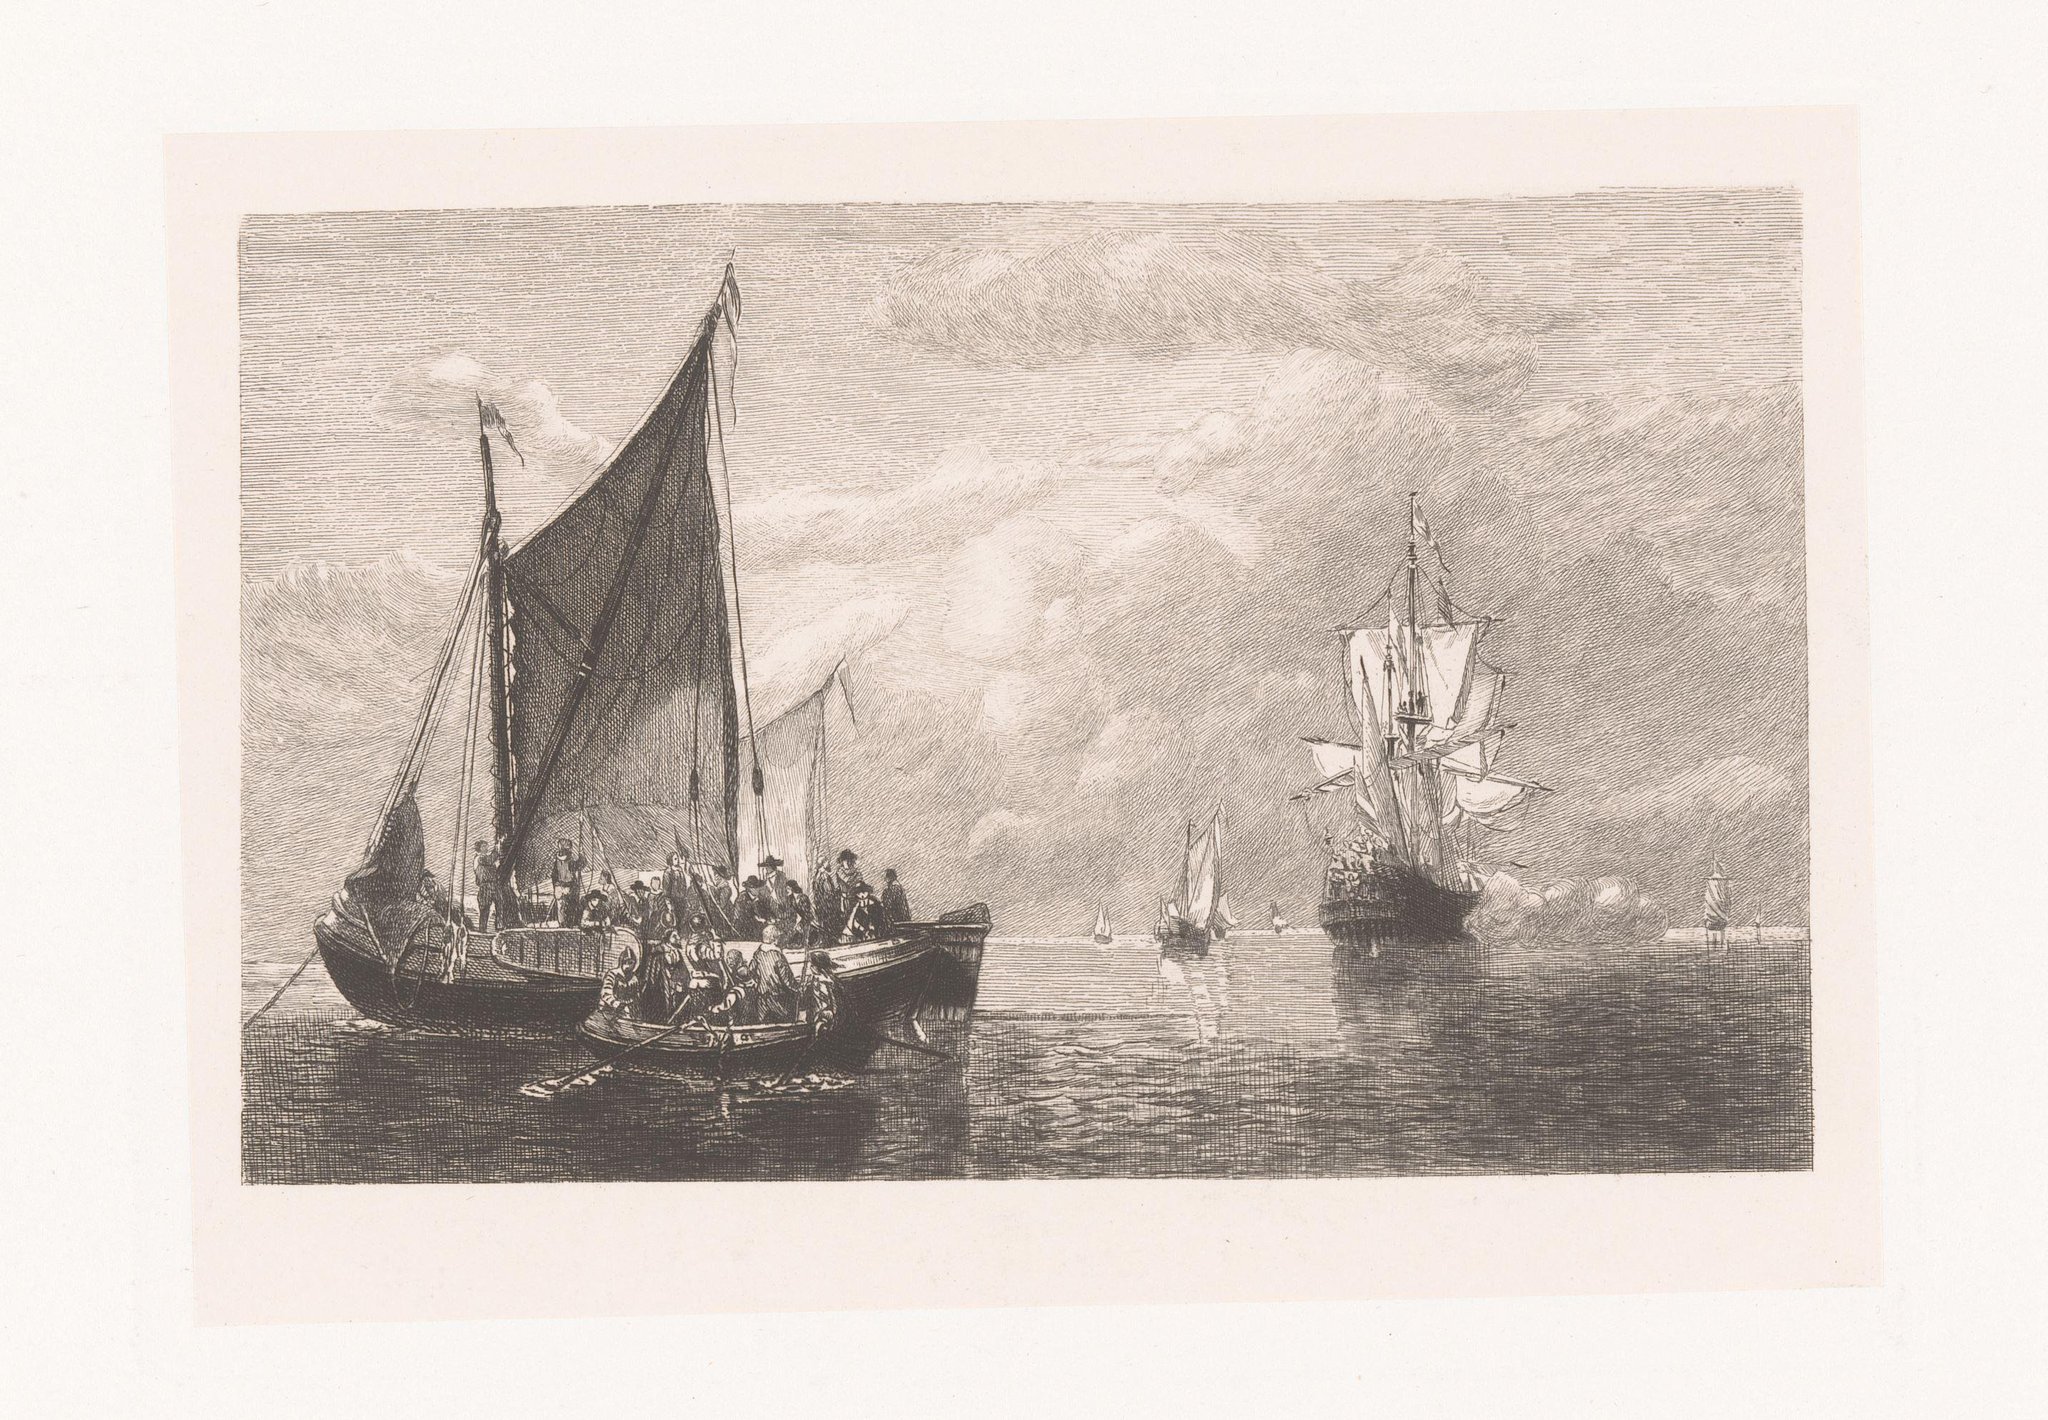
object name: print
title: Zeegezicht met schip met soldaten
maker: marie louveau-rouveyre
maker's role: print maker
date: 1878-1880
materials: paper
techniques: etching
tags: sea (seascape), warfare; military affairs (+ naval force)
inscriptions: collector's mark: Lugt 2228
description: Op de achtergrond een oorlogsschip dat een schot lost.